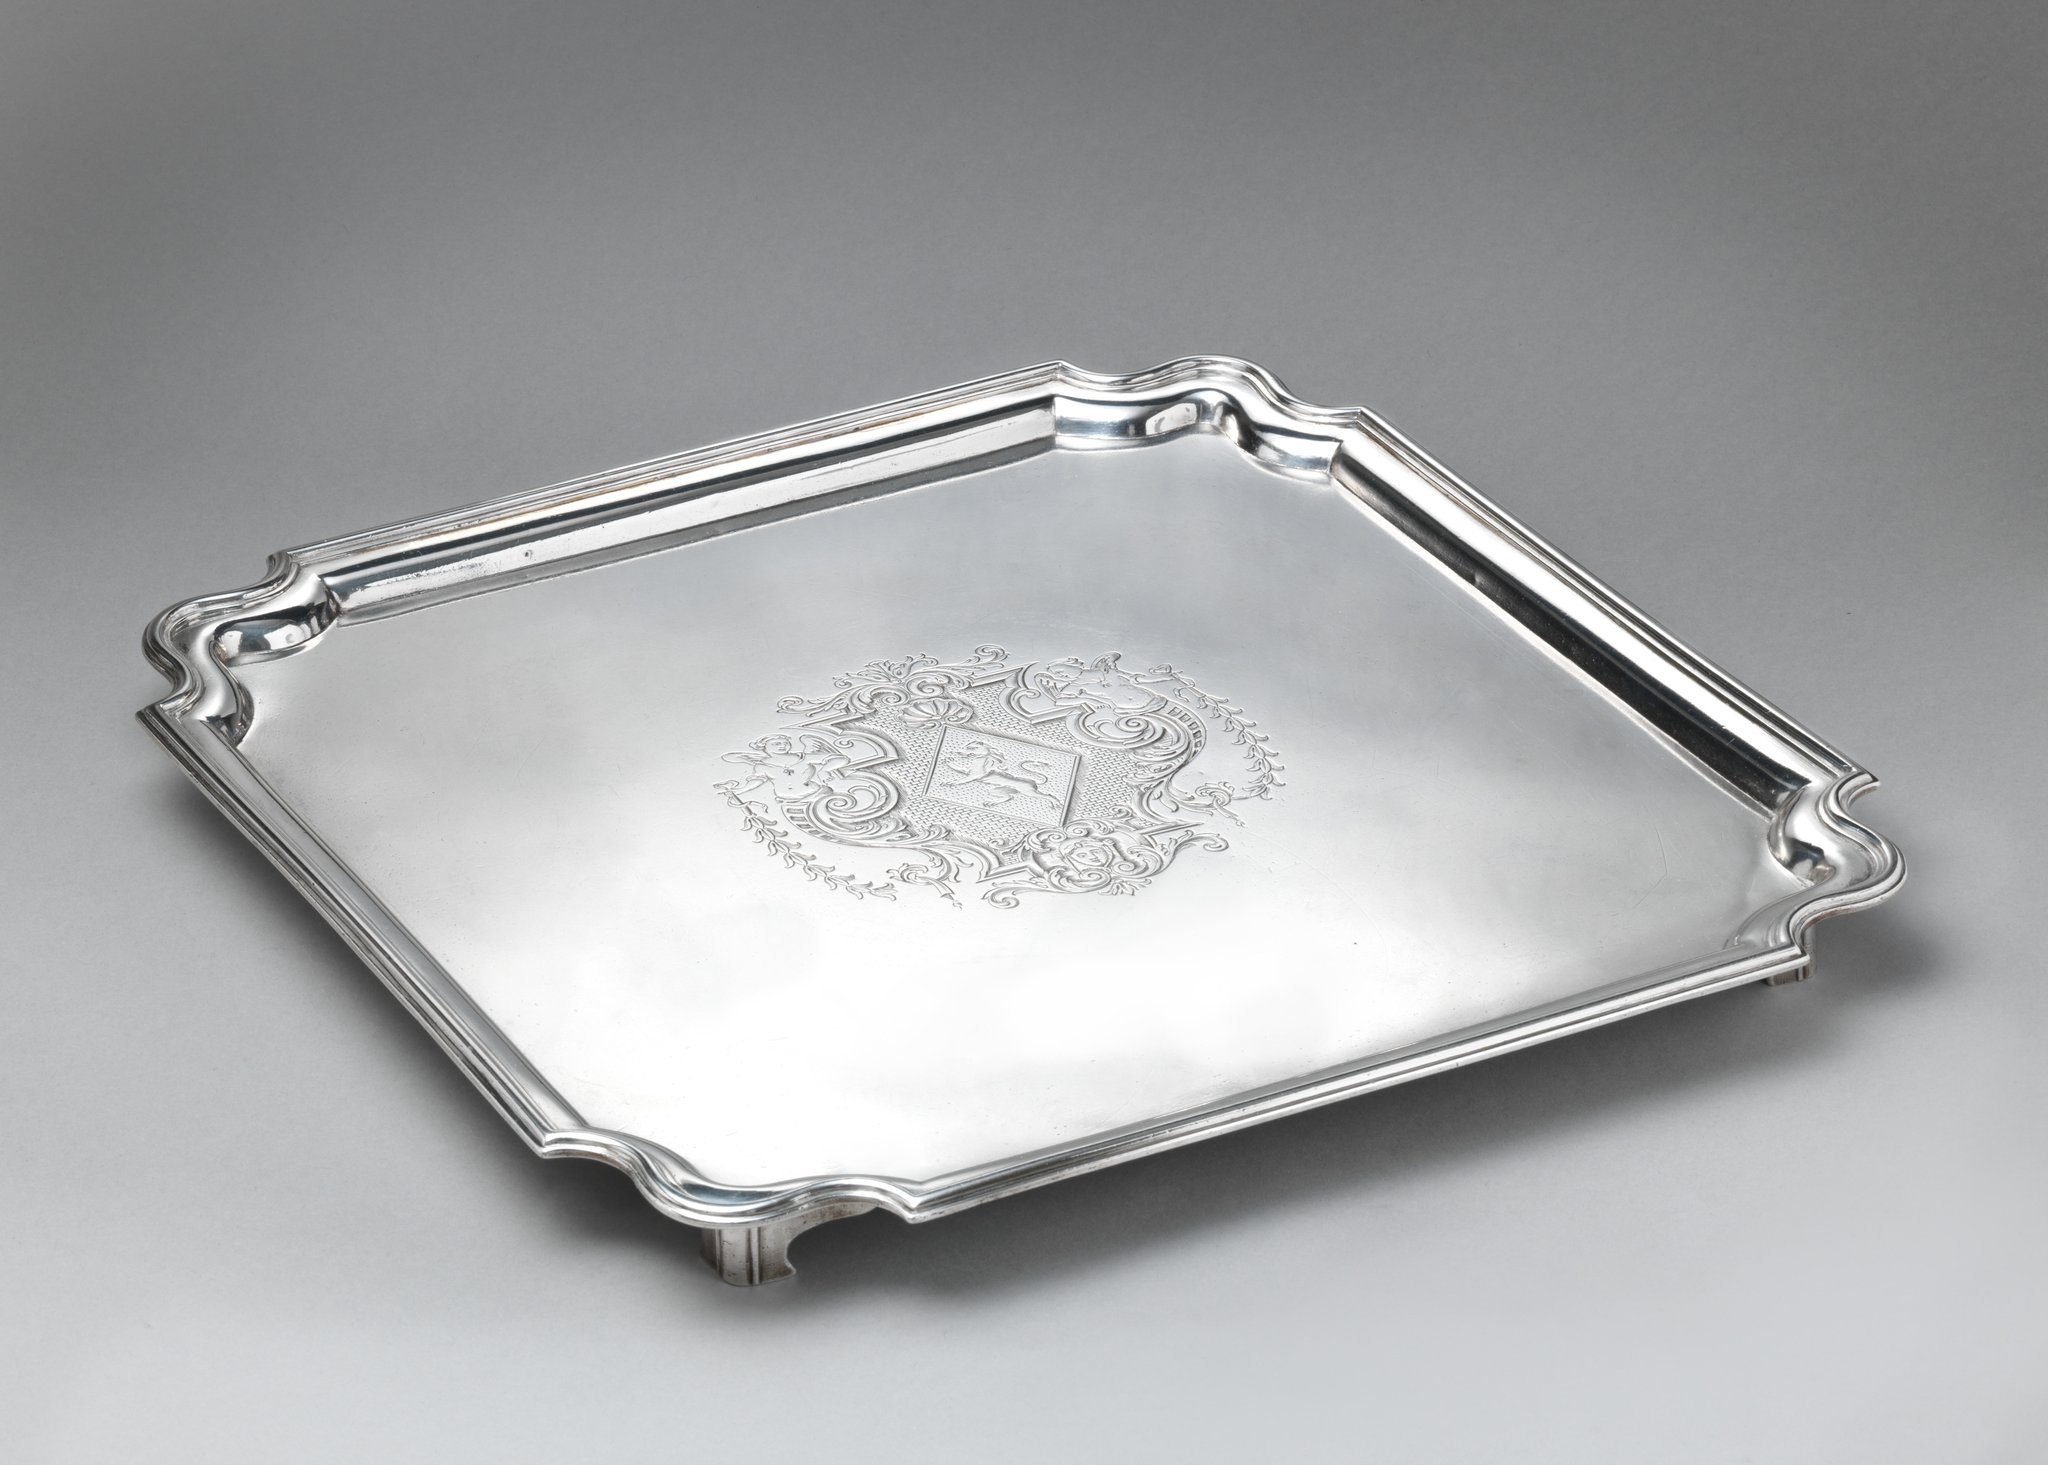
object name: salver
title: Square salver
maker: david willaume ii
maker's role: maker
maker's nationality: british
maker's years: 1693-1761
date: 1730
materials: silver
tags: coat of arms